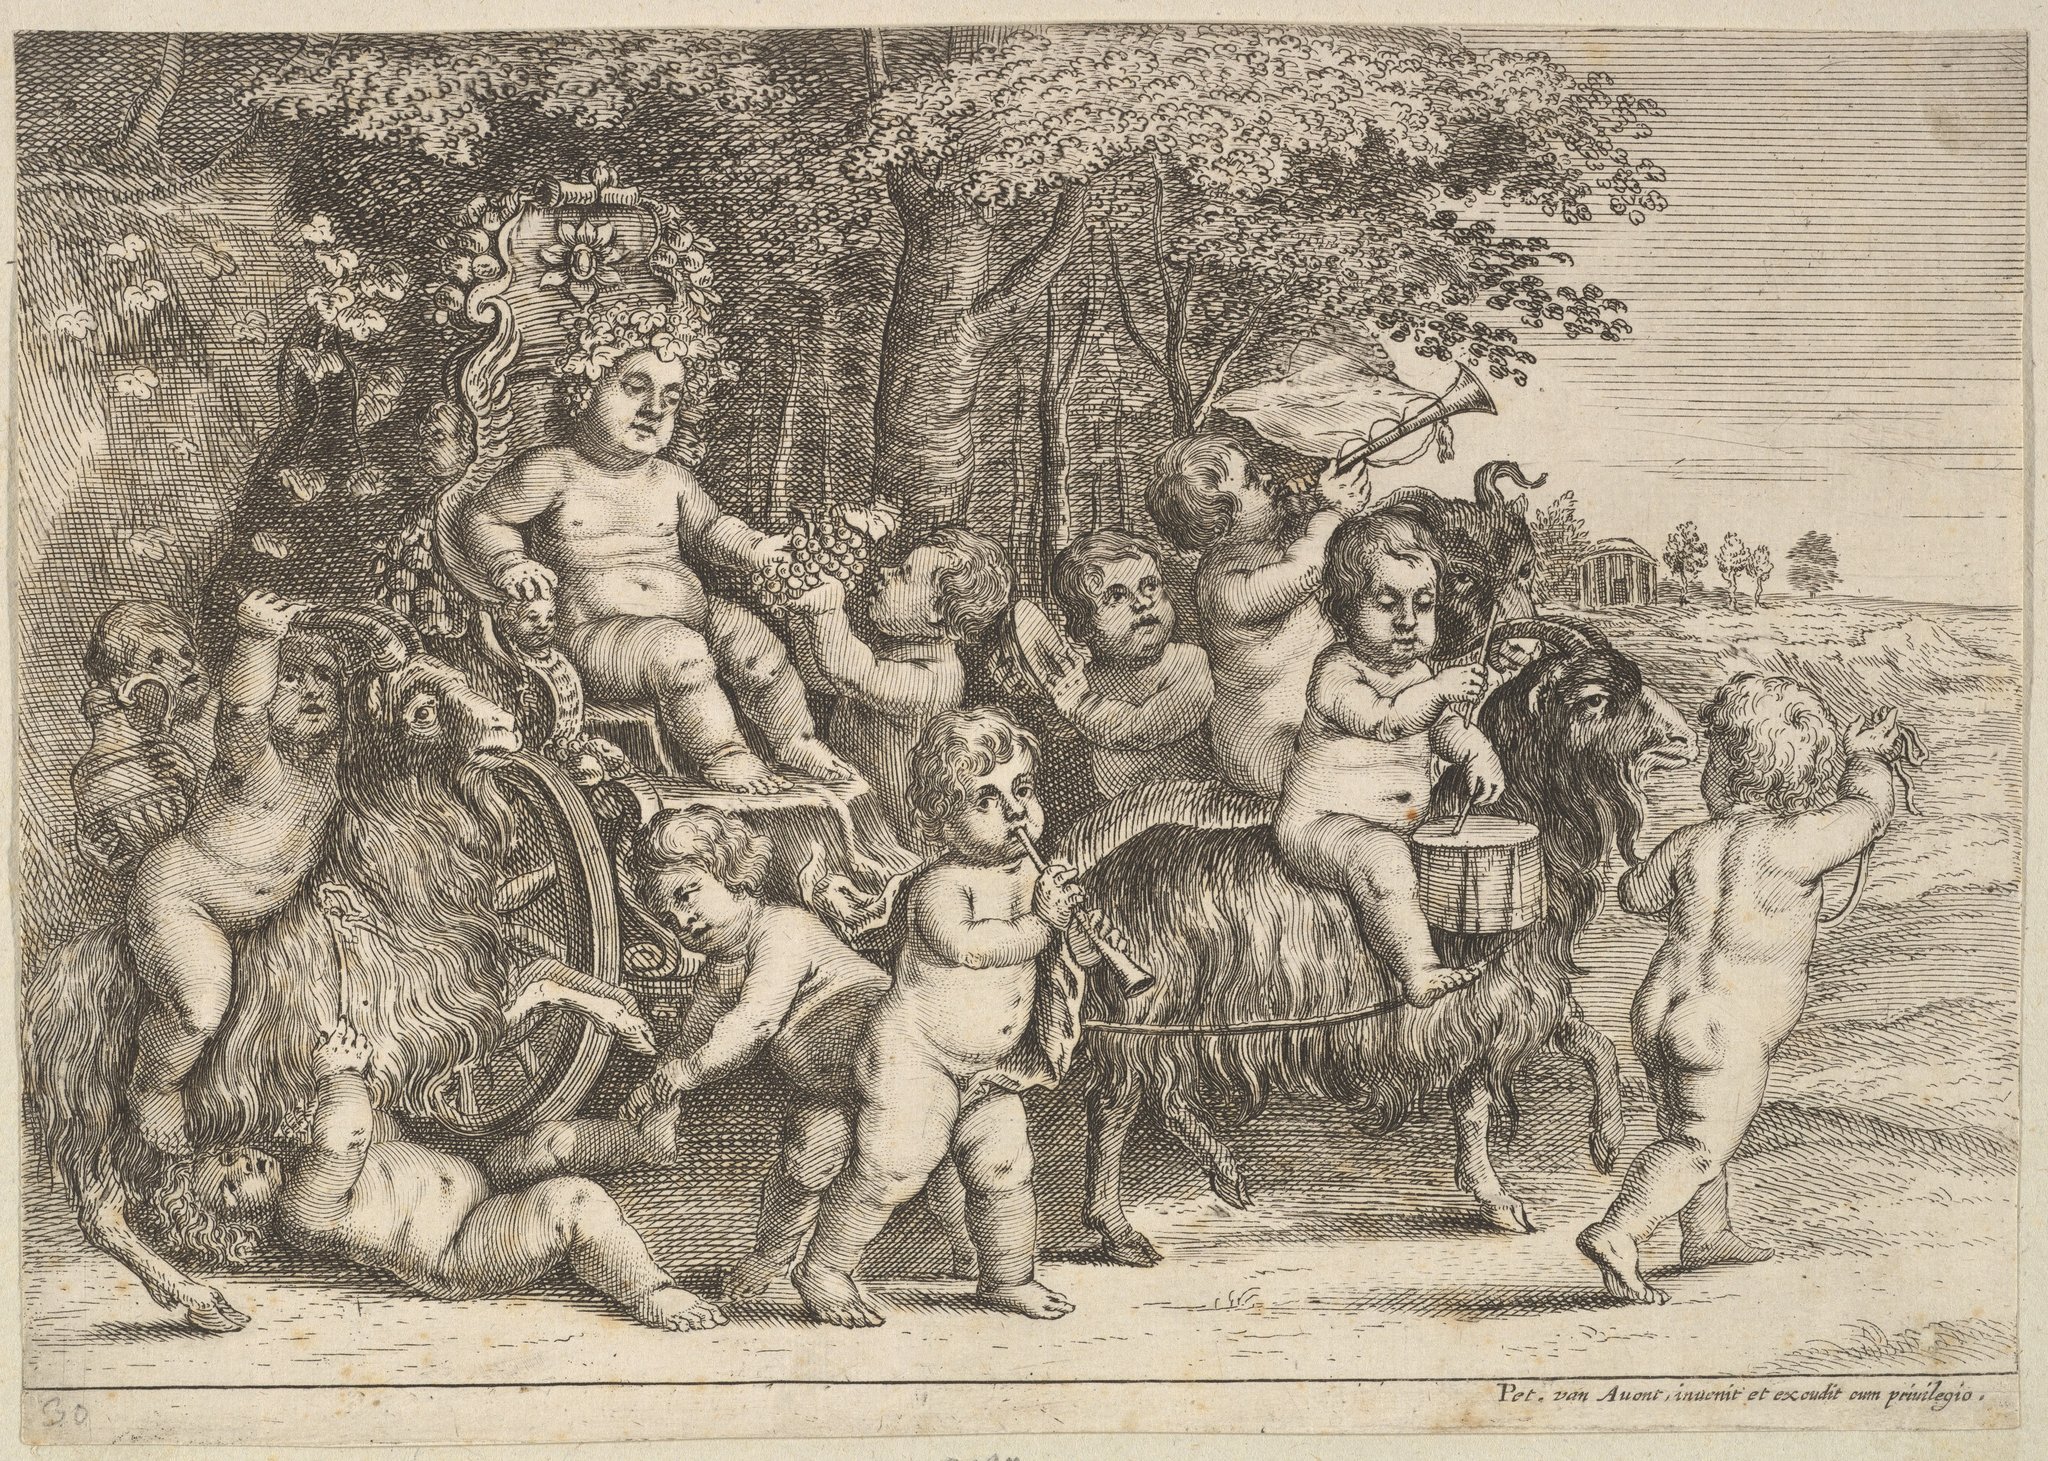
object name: print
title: Eleven boys and three goats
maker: wenceslaus hollar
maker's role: artist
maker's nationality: bohemian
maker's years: 1607-1677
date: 1646-1654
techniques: etching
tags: boys,drums,goats